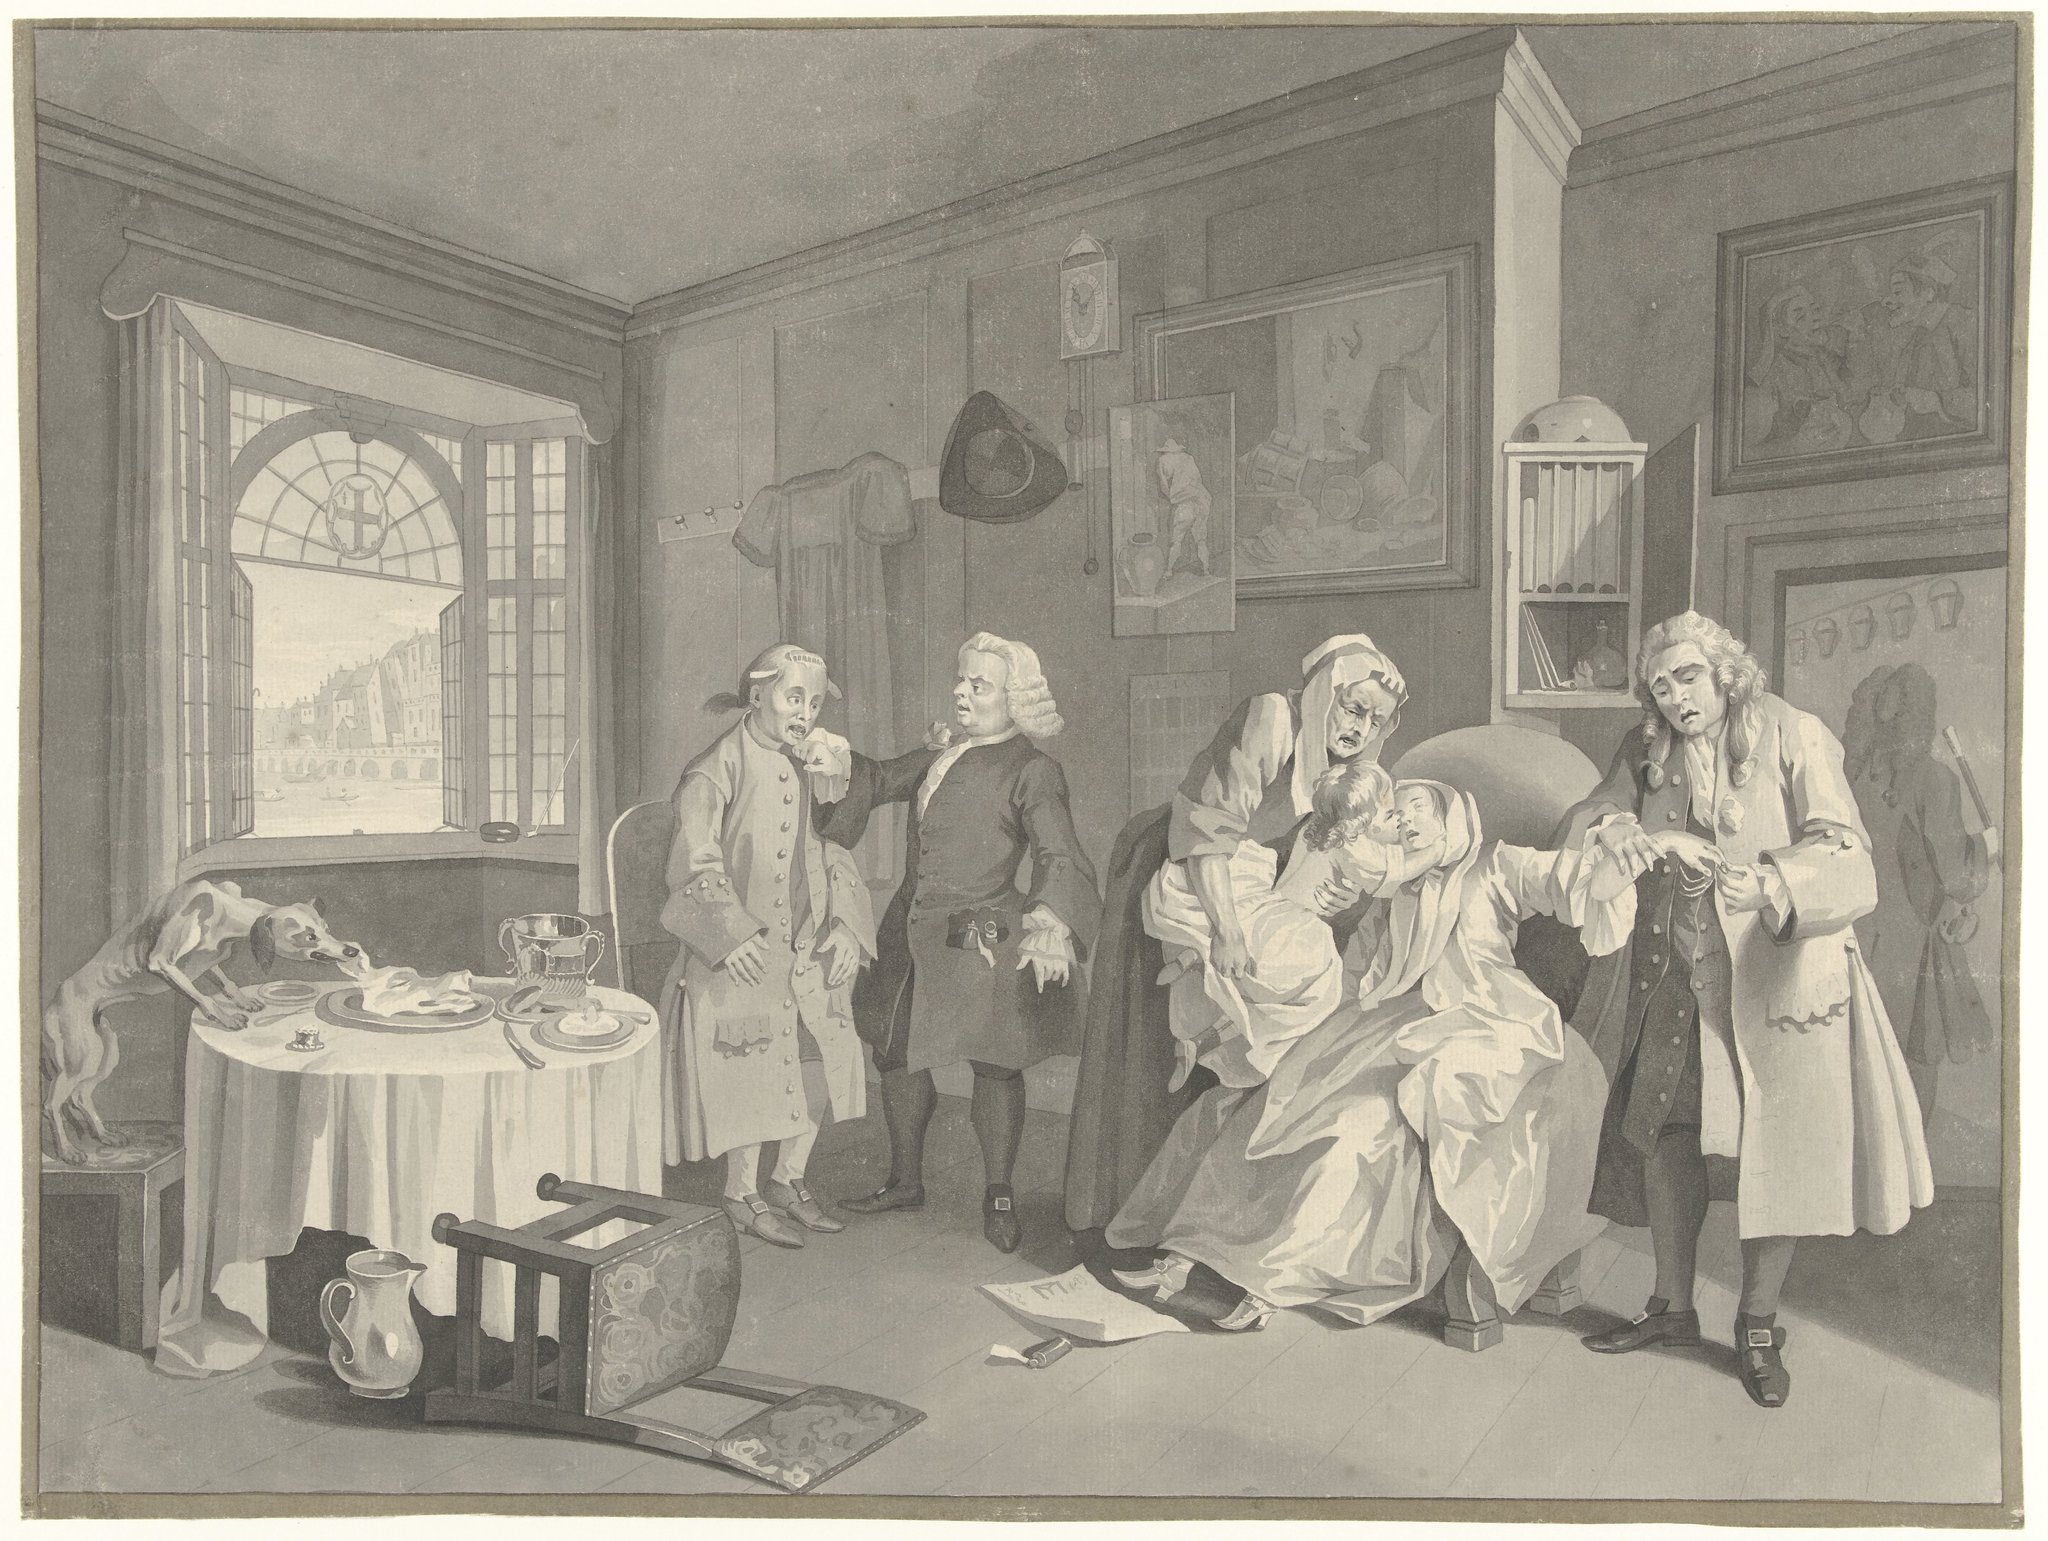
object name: drawing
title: Le mariage à la Mode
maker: cornelis ploos van amstel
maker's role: draughtsman, print maker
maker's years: 1726-1798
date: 1748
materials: ink, paper, pencil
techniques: brush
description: Blad 6 uit een serie van 6 bladen. Met apart opgezet en gedateerd inhoudsblad (volgens JWN in ander handschrift dan dat van Ploos van Amstel).